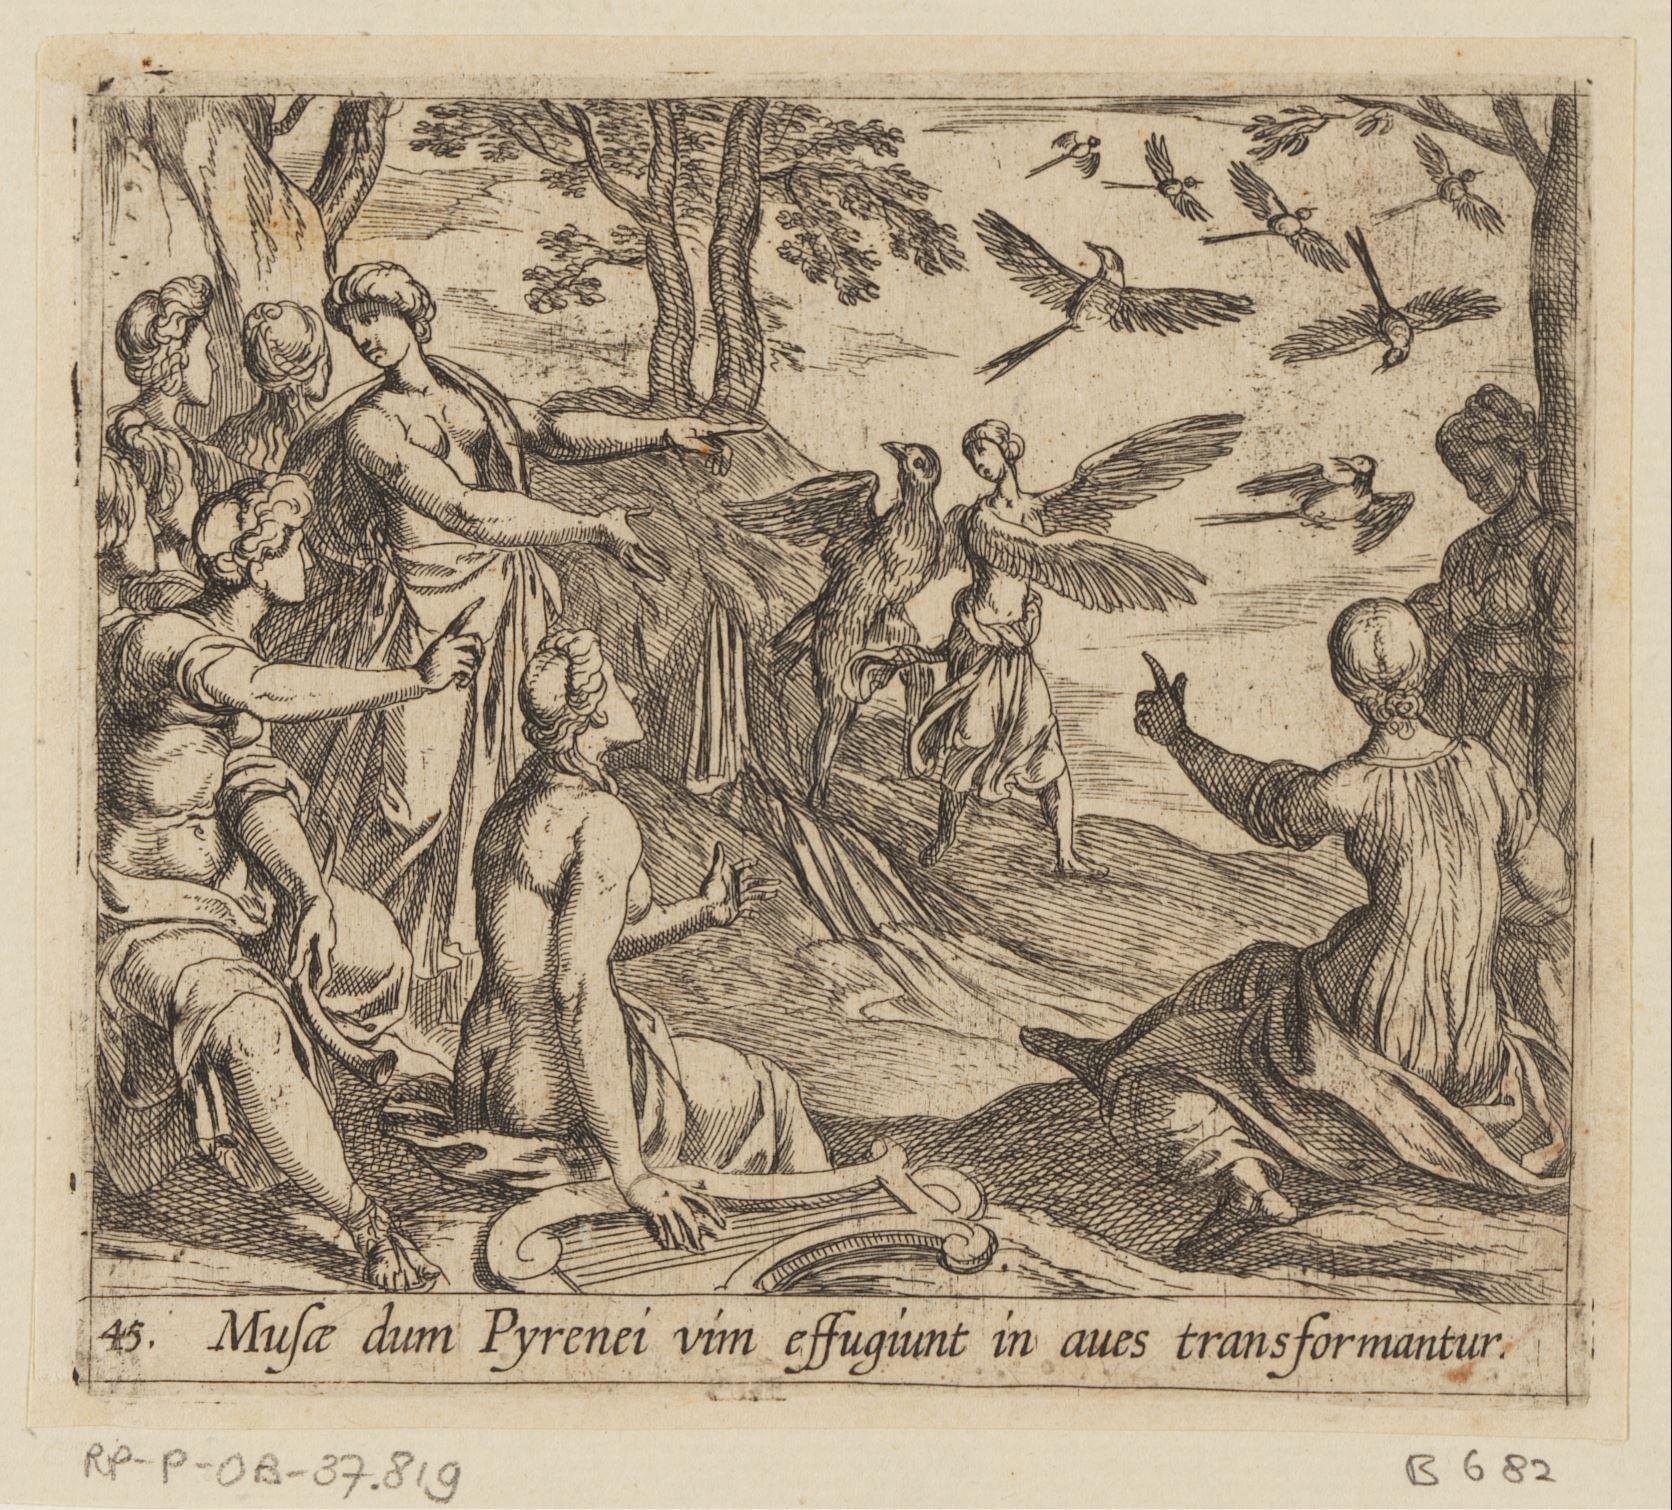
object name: print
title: Metamorfosen van Ovidius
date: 1606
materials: paper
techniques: etching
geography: italy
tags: pierides changed into magpies: the pierides (emathides) are changed into magpies by the muses, who have defeated them in a musical contest (ovid, metamorphoses v 670)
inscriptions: collector's mark: Lugt 240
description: Deze prent maakt deel uit van een reeks van 150 prenten (+ titelprent) met voorstellingen van de Metamorfosen van Ovidius.